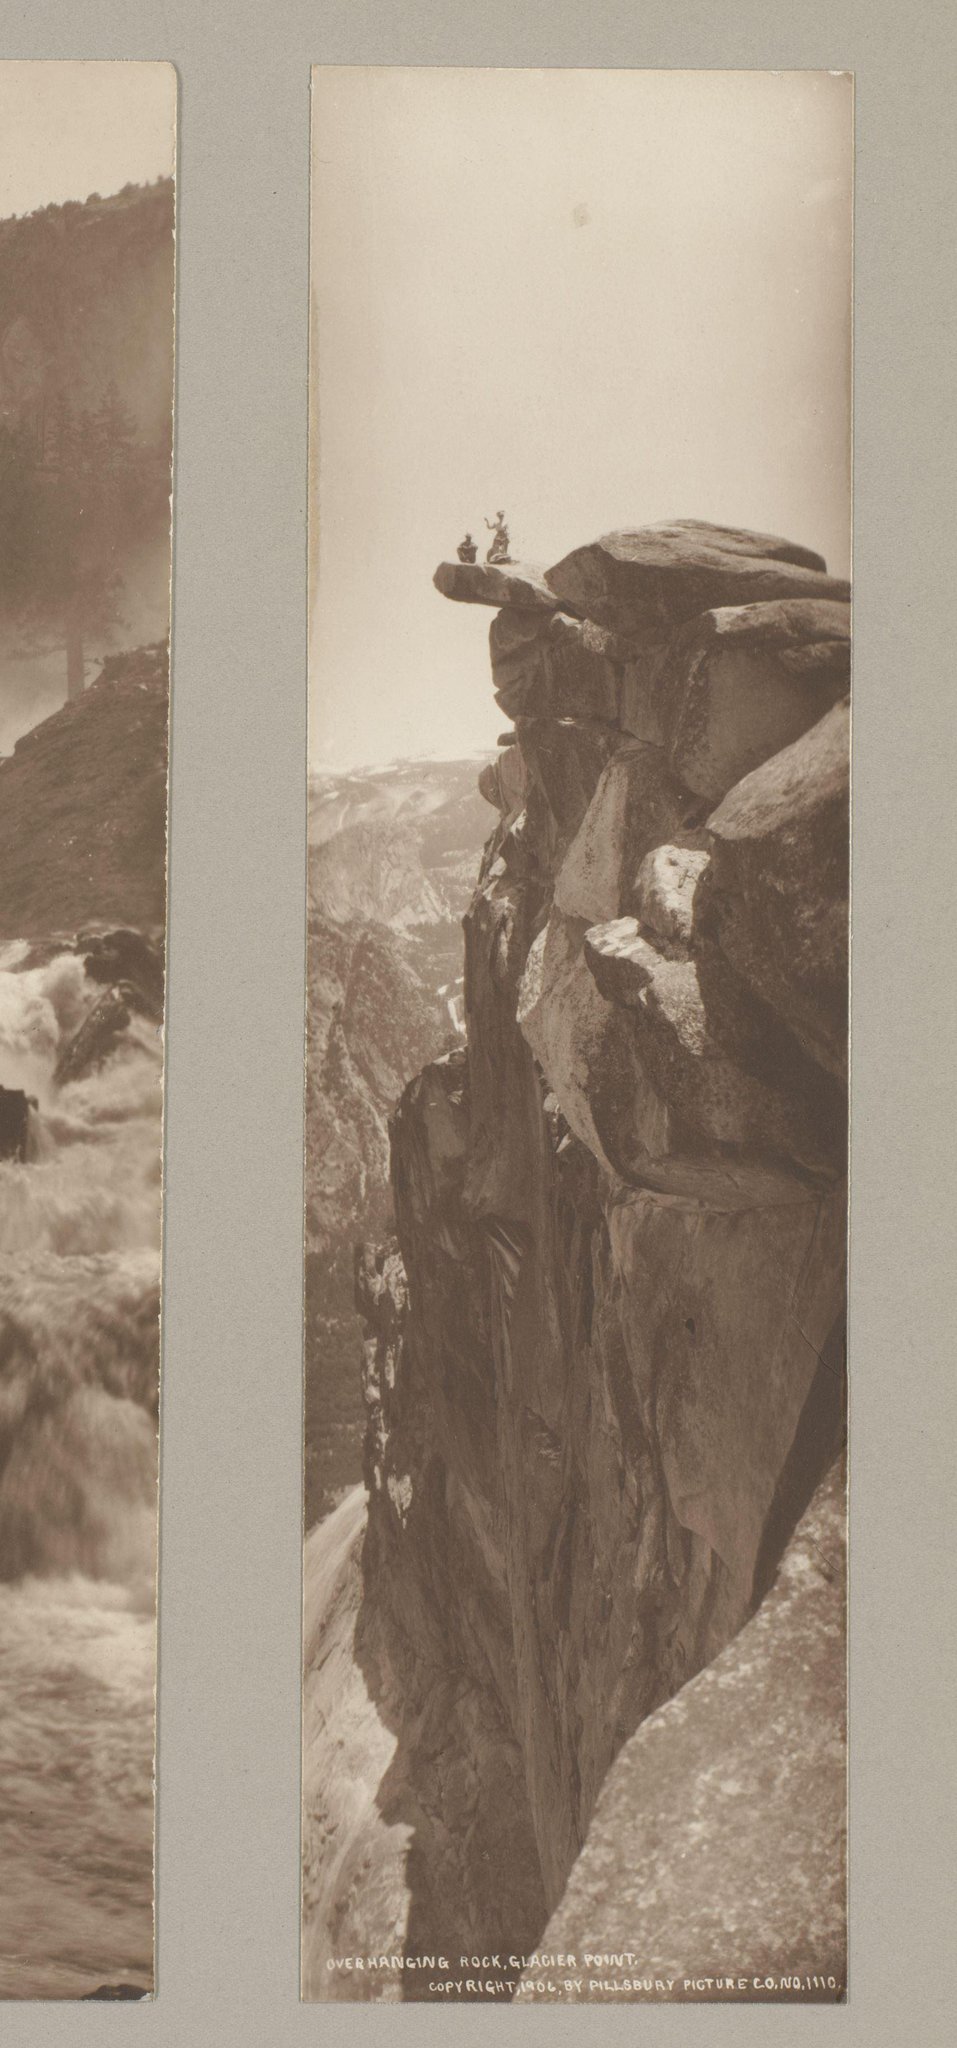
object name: photograph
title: Overhanging Rock, Glacier Point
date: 1906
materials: cardboard, photographic support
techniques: gelatin silver print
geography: california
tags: californië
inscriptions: annotation: ‘4. Yosemete-Valley’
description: Onder de titel staat: Copyright, 1906, by Pillsbury Picture Co. No. 1110.